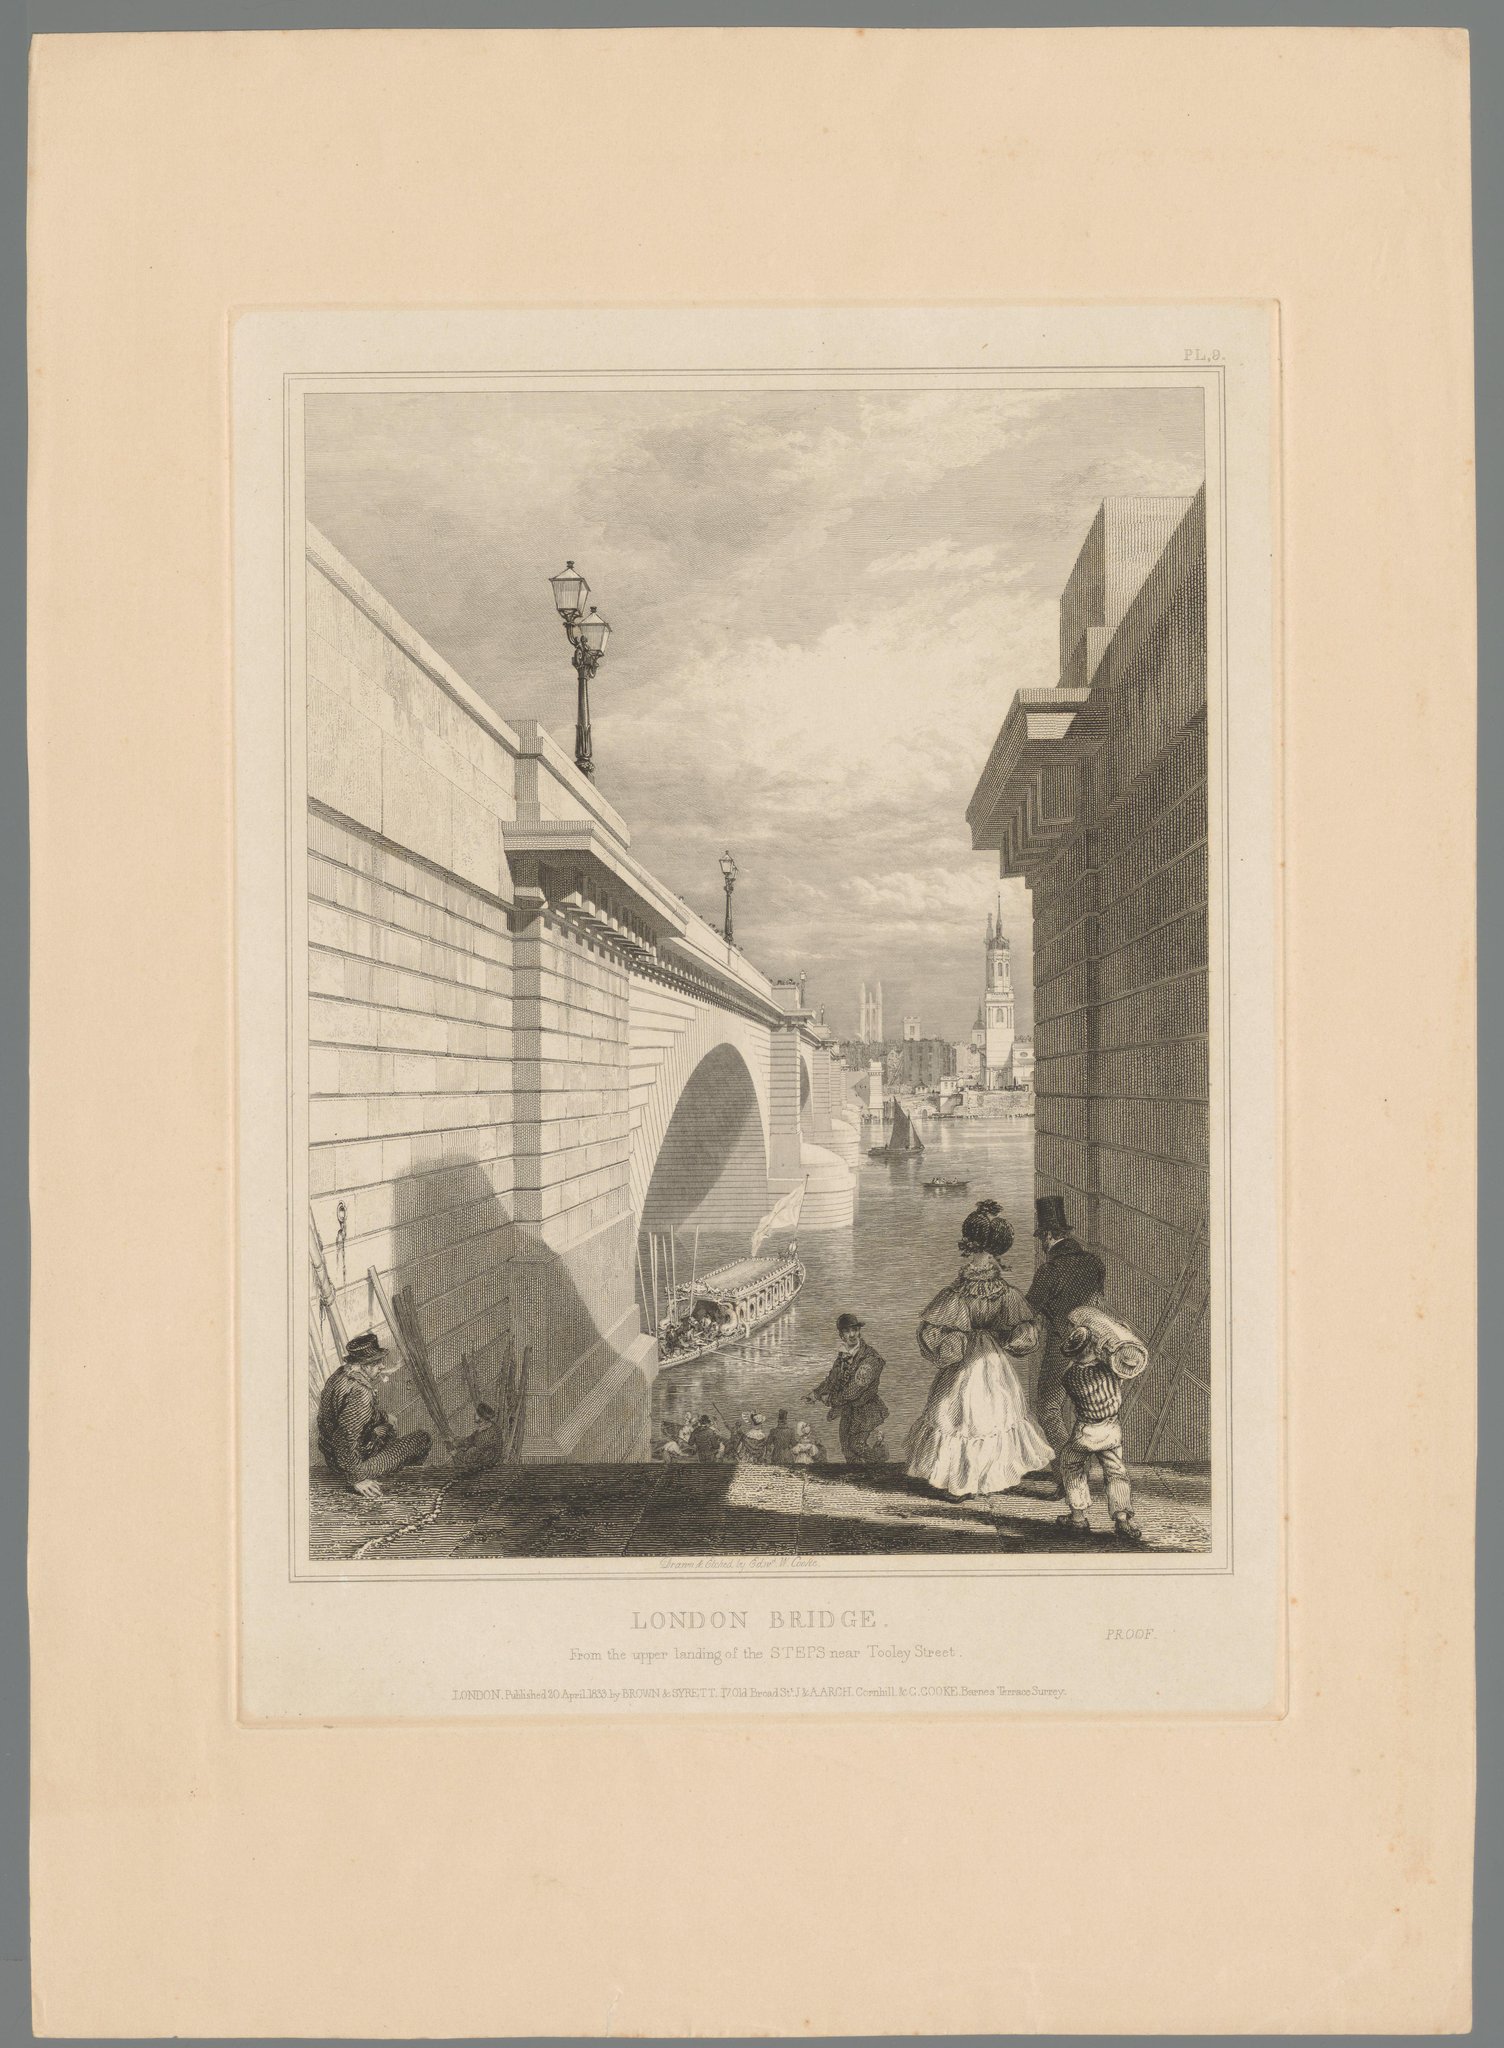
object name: print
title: Gezichten op de oude en nieuwe London Bridge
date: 1804-1833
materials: paper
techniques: etching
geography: london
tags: rowing-boat, canoe, etc., bridge in city across river, canal, etc., street (+ city(-scape) with figures, staffage)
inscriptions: collector's mark: Lugt 2165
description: Bij de prentenserie hoort een titelprent uit 1833 en een beschrijving van de bruggen.